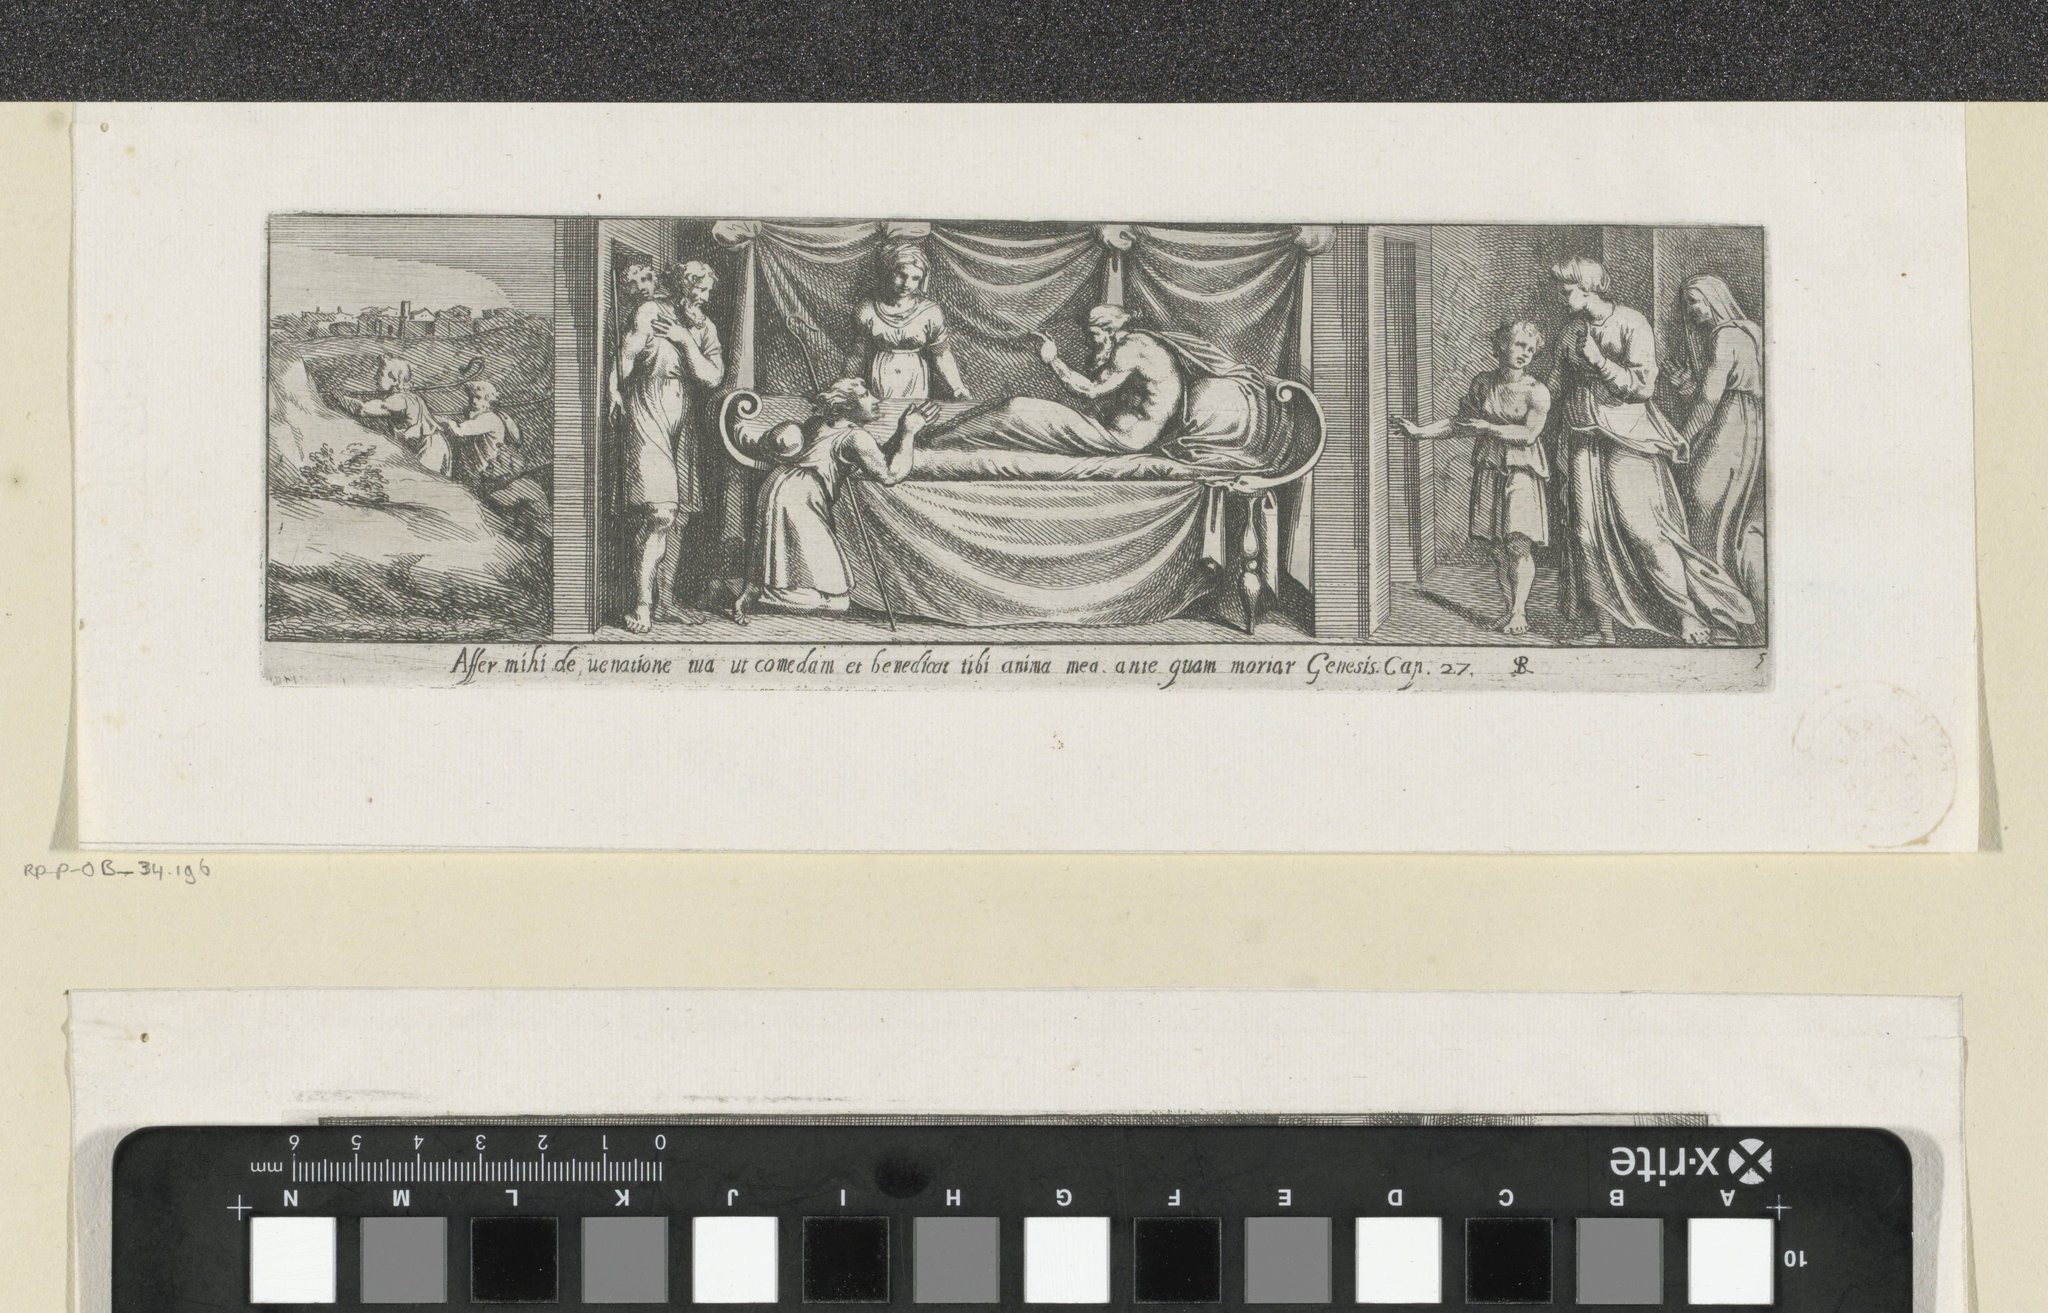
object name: print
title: Asser mihi venantione tua ut comedam et benedicat tibi anima mea ante quam moriar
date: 1645-1700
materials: paper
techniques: engraving, etching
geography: vatican city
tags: the meeting between esau and jacob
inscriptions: collector's mark: Lugt 240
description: Isaak ligt in bed en praat tegen Esau, die aan het voeteneinde staat. Hij stuurt Esau uit om een stuk wild te schieten. Links vertrekt Esau voor de jacht. Rechts staan Jakob en Rebekka achter de deur mee te luisteren. Titel en verwijzing naar Bijbeltekst in ondermarge.